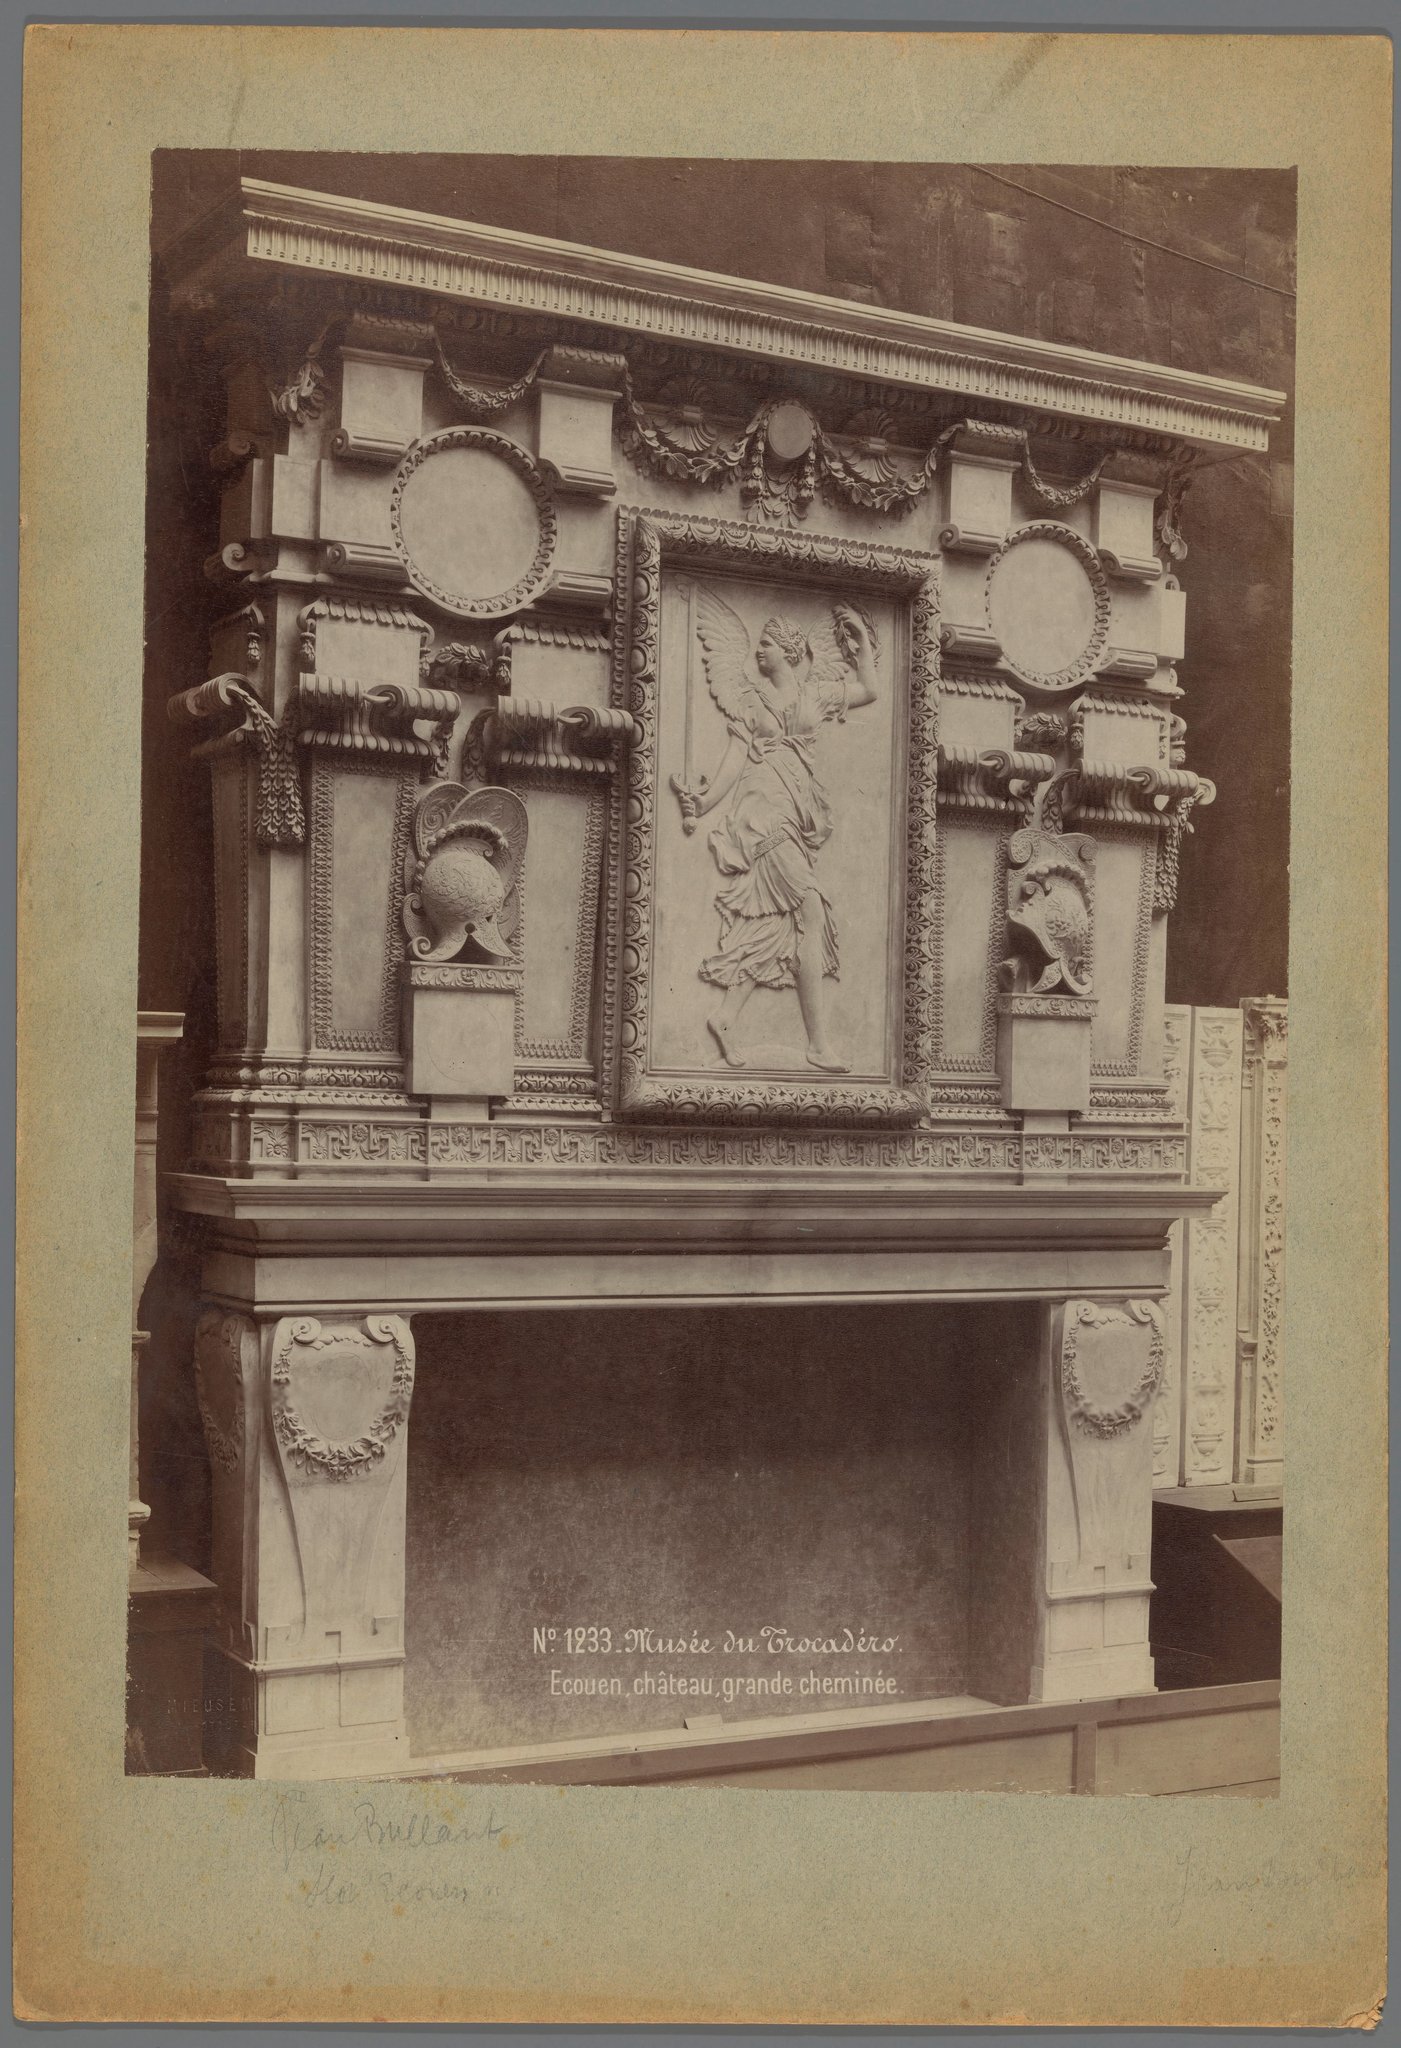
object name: photograph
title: Gipsafgietsel van een schouw in het Musée des monuments français te Parijs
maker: séraphin-médéric mieusement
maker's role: fotograaf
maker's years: 1840-1905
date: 1875-1900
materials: cardboard, photographic support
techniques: albumen print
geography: palais du trocadéro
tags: open hearth, fire-place, permanent exhibition, museum, sculpture (+ relief ~ sculpture)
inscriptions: name: ‘KUNSTBOEKHANDEL J. A. G. DE LEUR PHOTOGRAAF - UITGEVER HUIGENSPARK, 40b. DEN HAAG.’, number: ‘No. 1233.’, name: ‘MIEUSEMENT PHOTOGRAPHE’, inscription: ‘Jean Bullant’, collector's mark: Lugt 3937, inscription: ‘MONUMENTS HISTORIQUES’